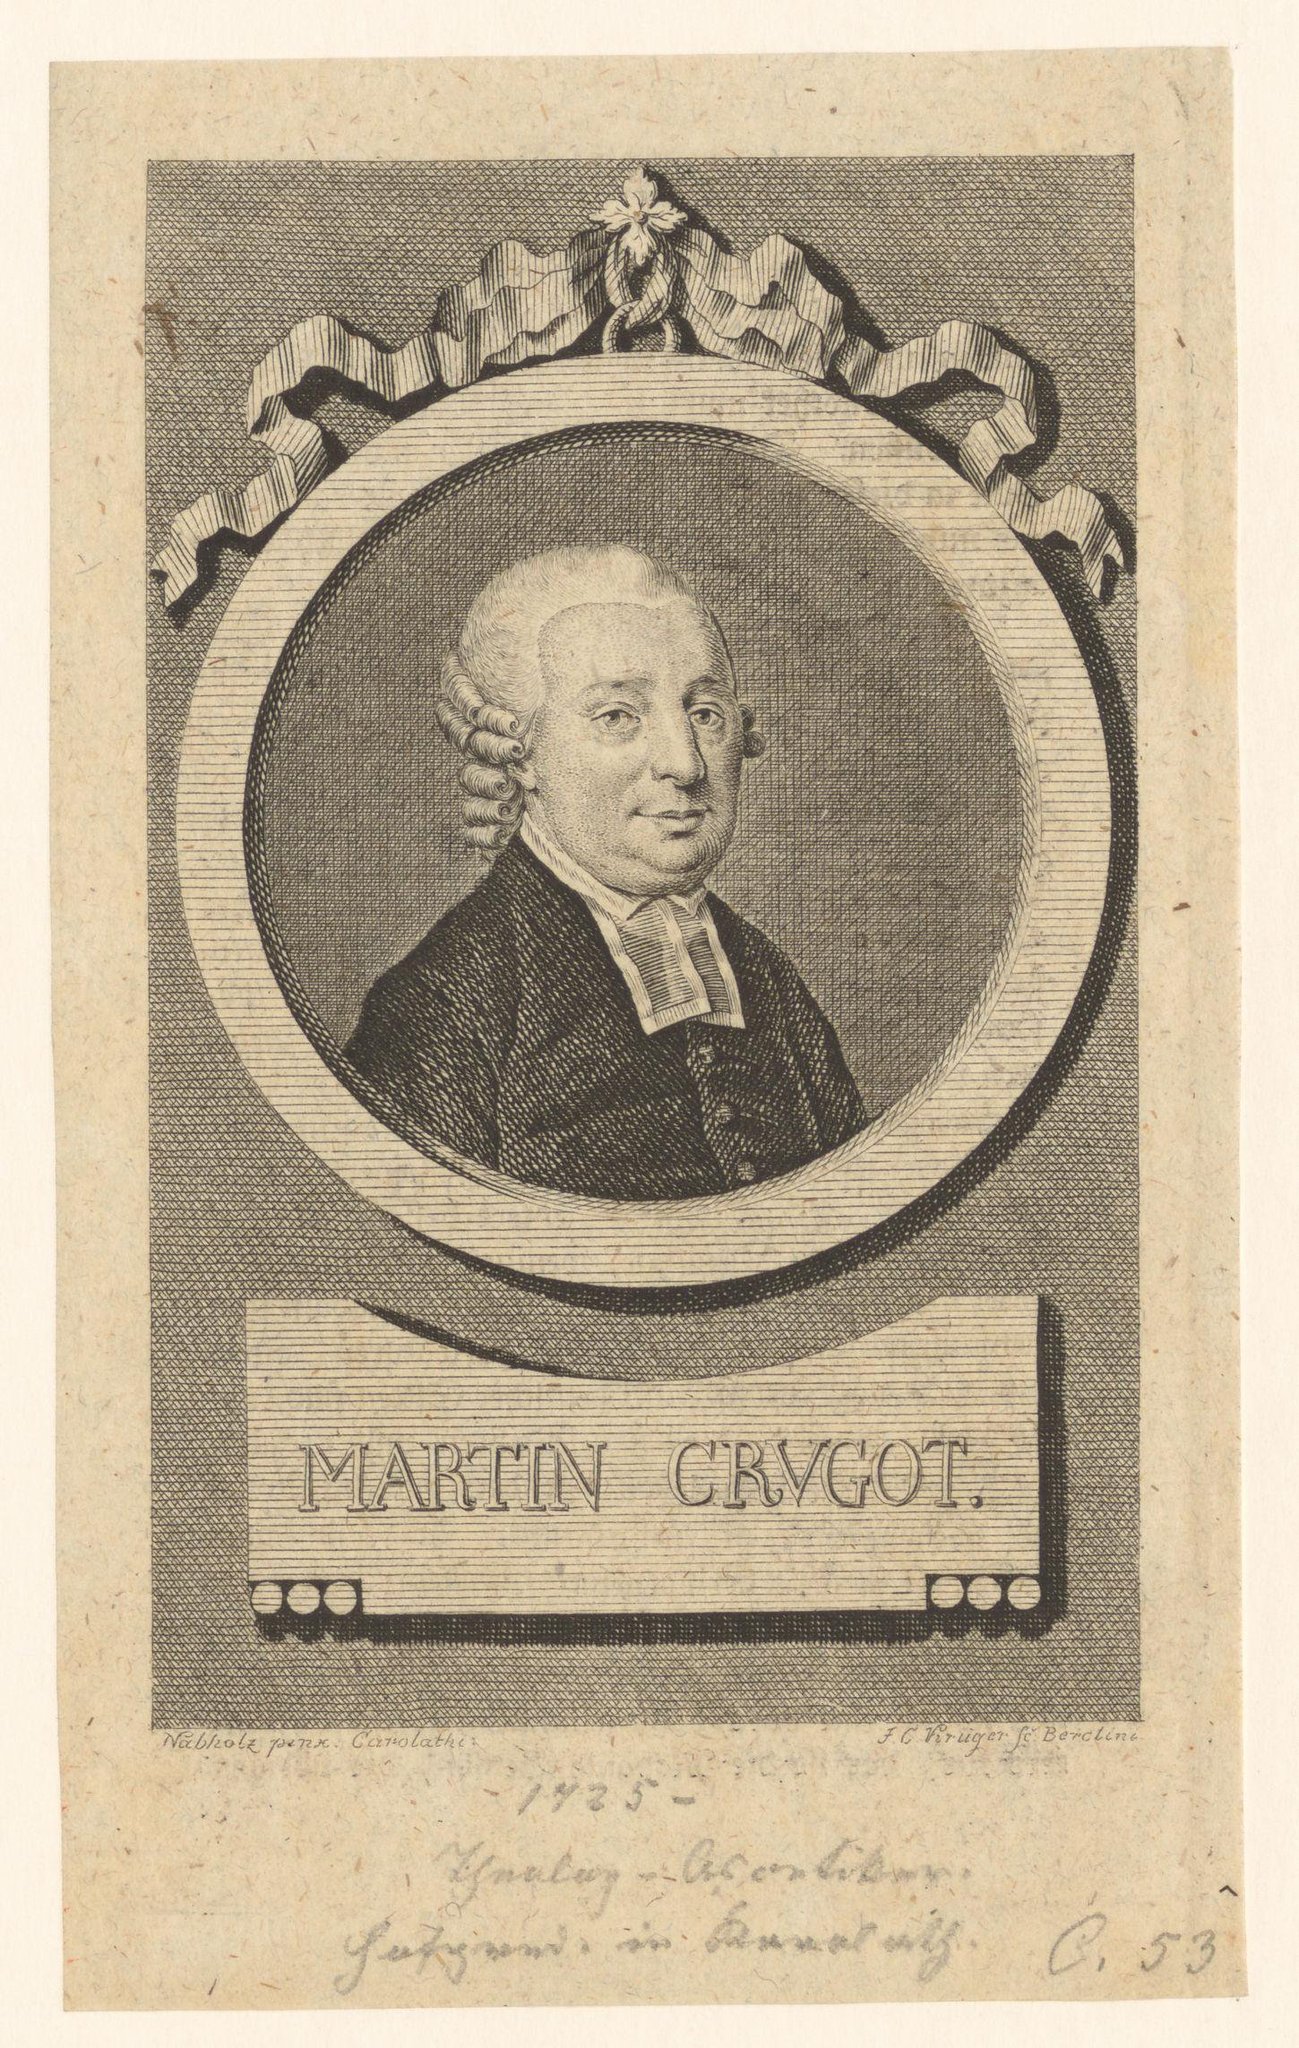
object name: print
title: Portret van Martin Crugot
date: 1778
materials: paper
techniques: engraving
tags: historical persons, mathematics (+ portrait of scholar, scientist)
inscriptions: collector's mark: Lugt 2228